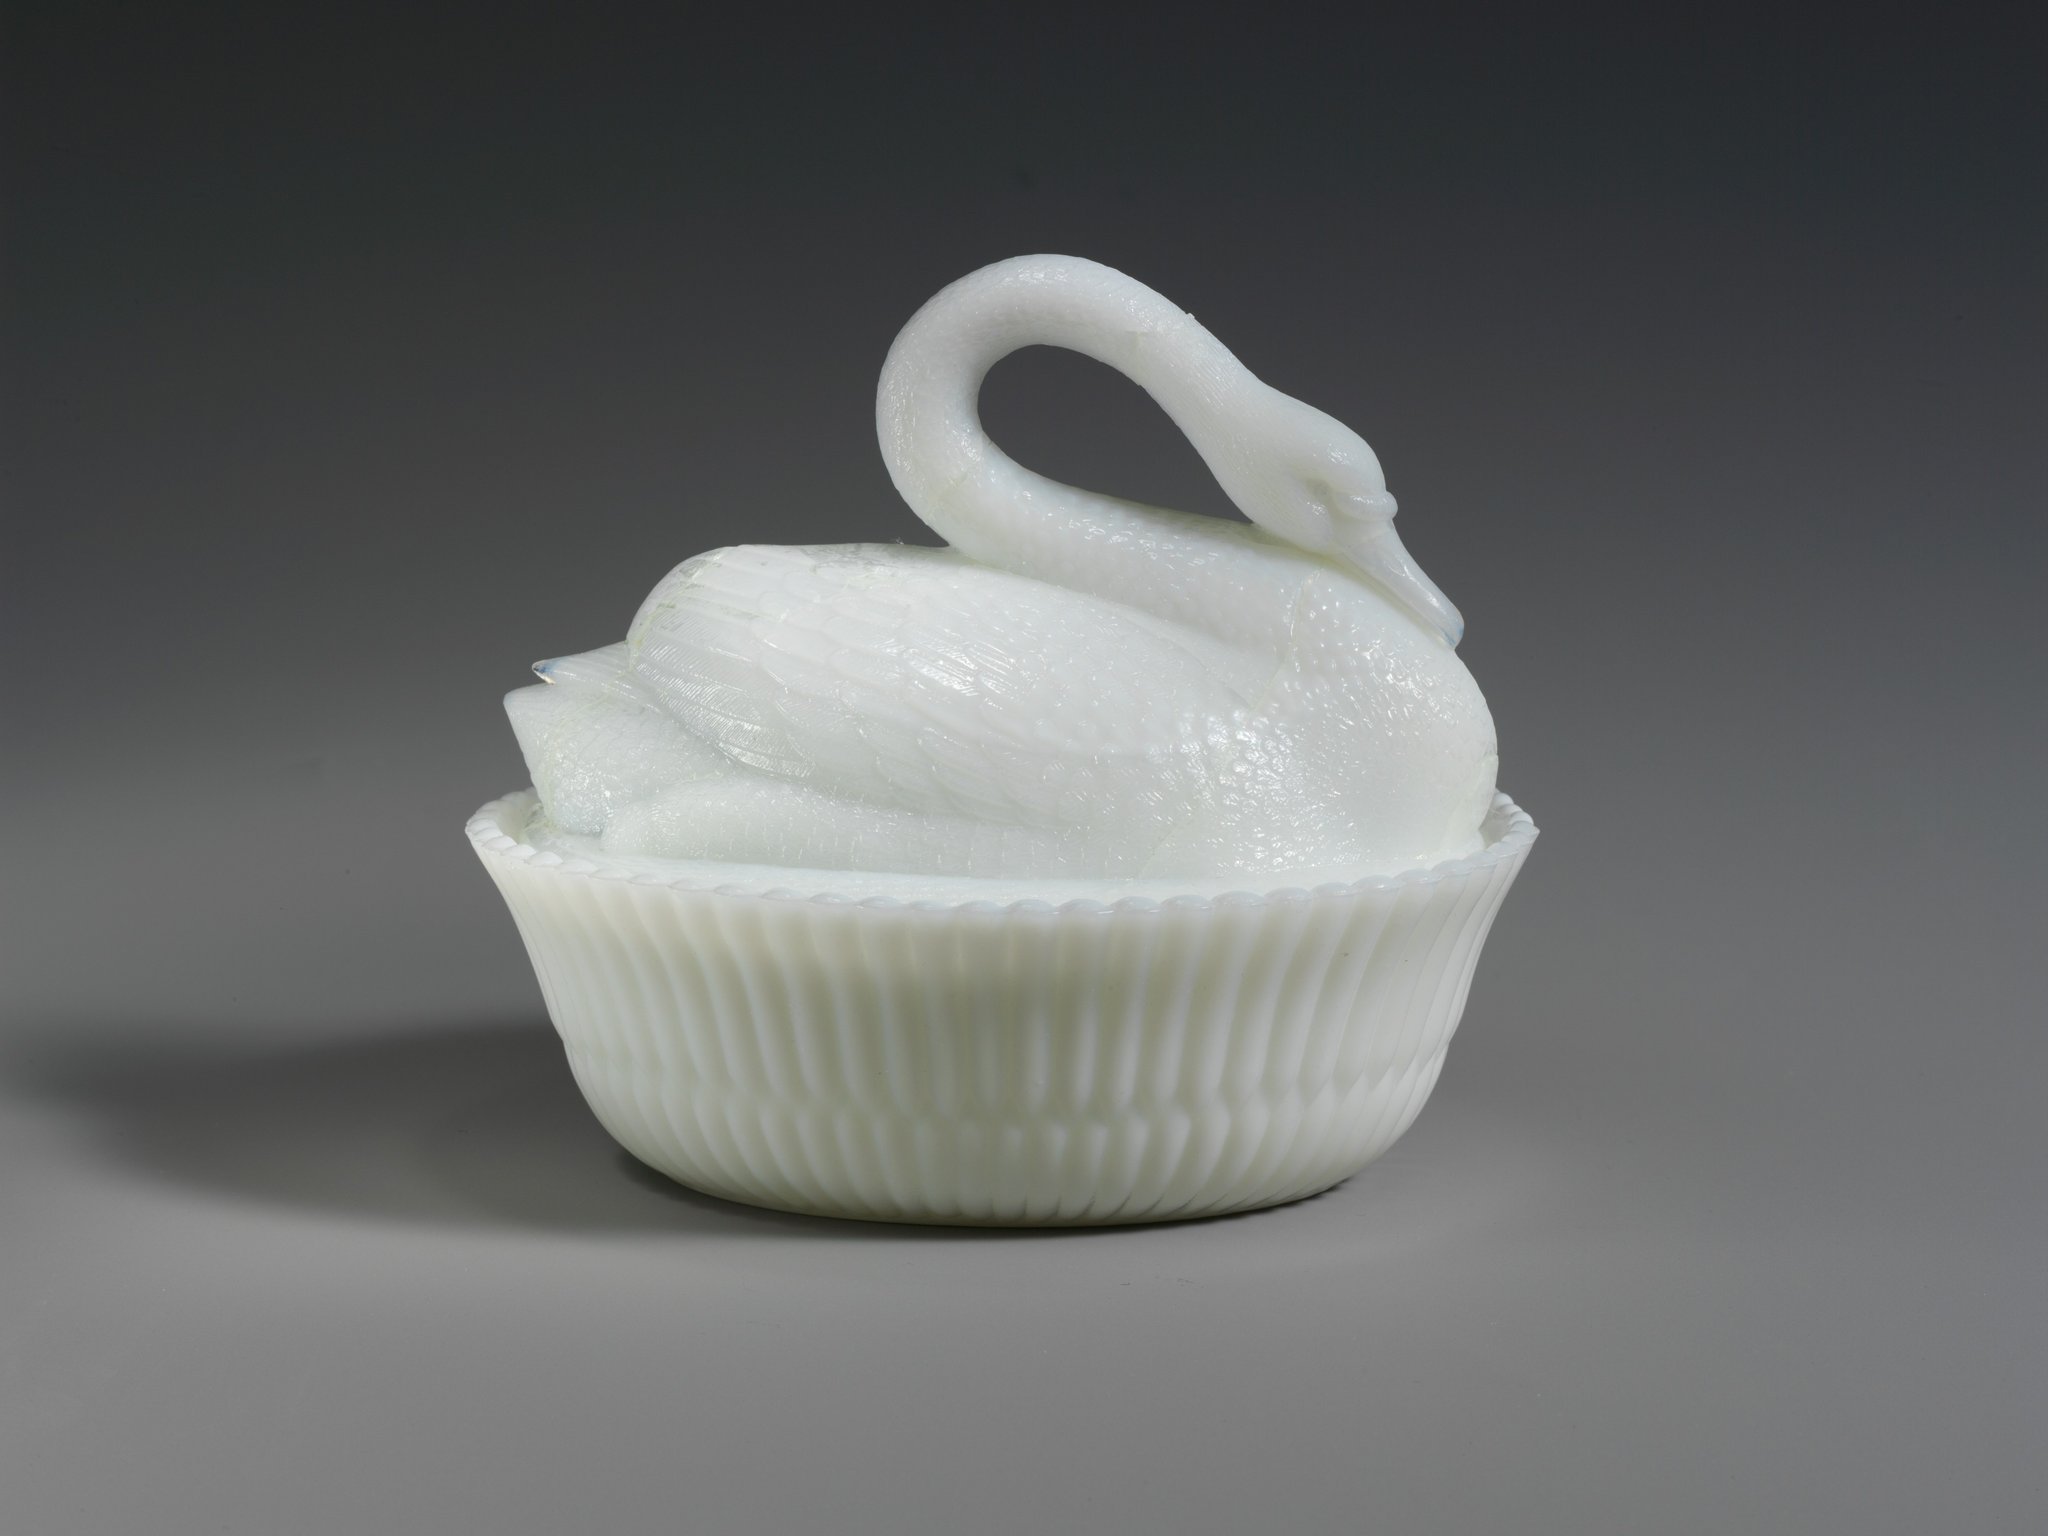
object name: dish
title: Figure Dish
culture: american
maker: mckee and brothers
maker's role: maker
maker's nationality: american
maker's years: 1856-1889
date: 1880-1890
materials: glass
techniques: pressed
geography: united states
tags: swans